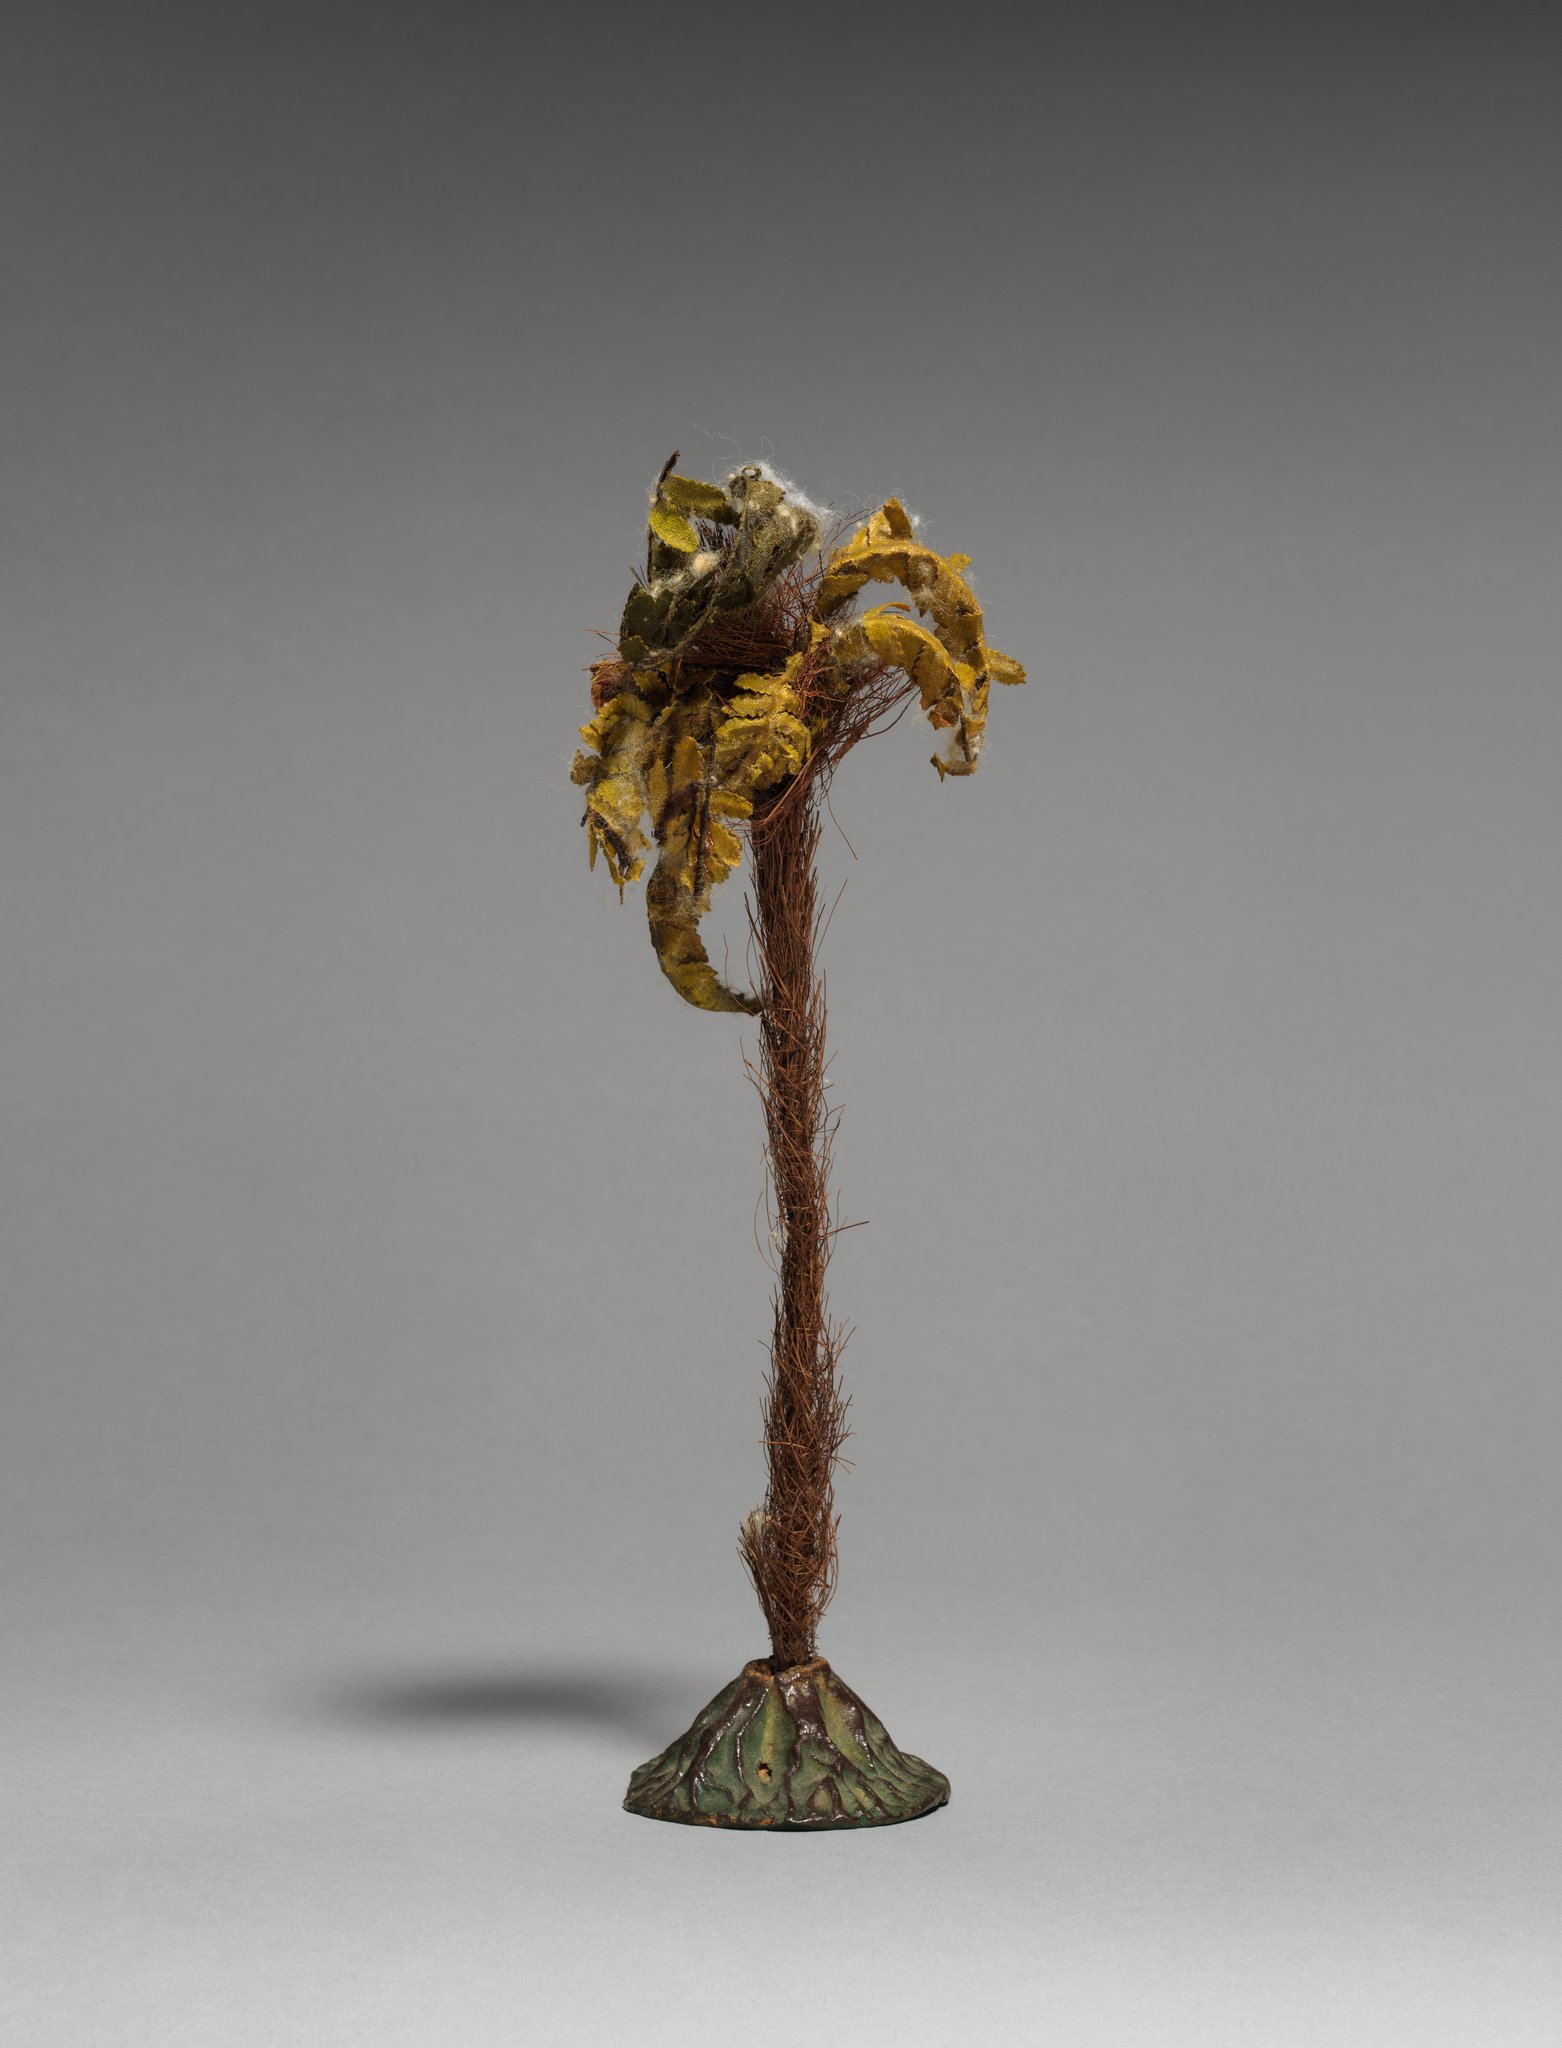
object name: crèche accessory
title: Tree (crèche accessory)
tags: trees